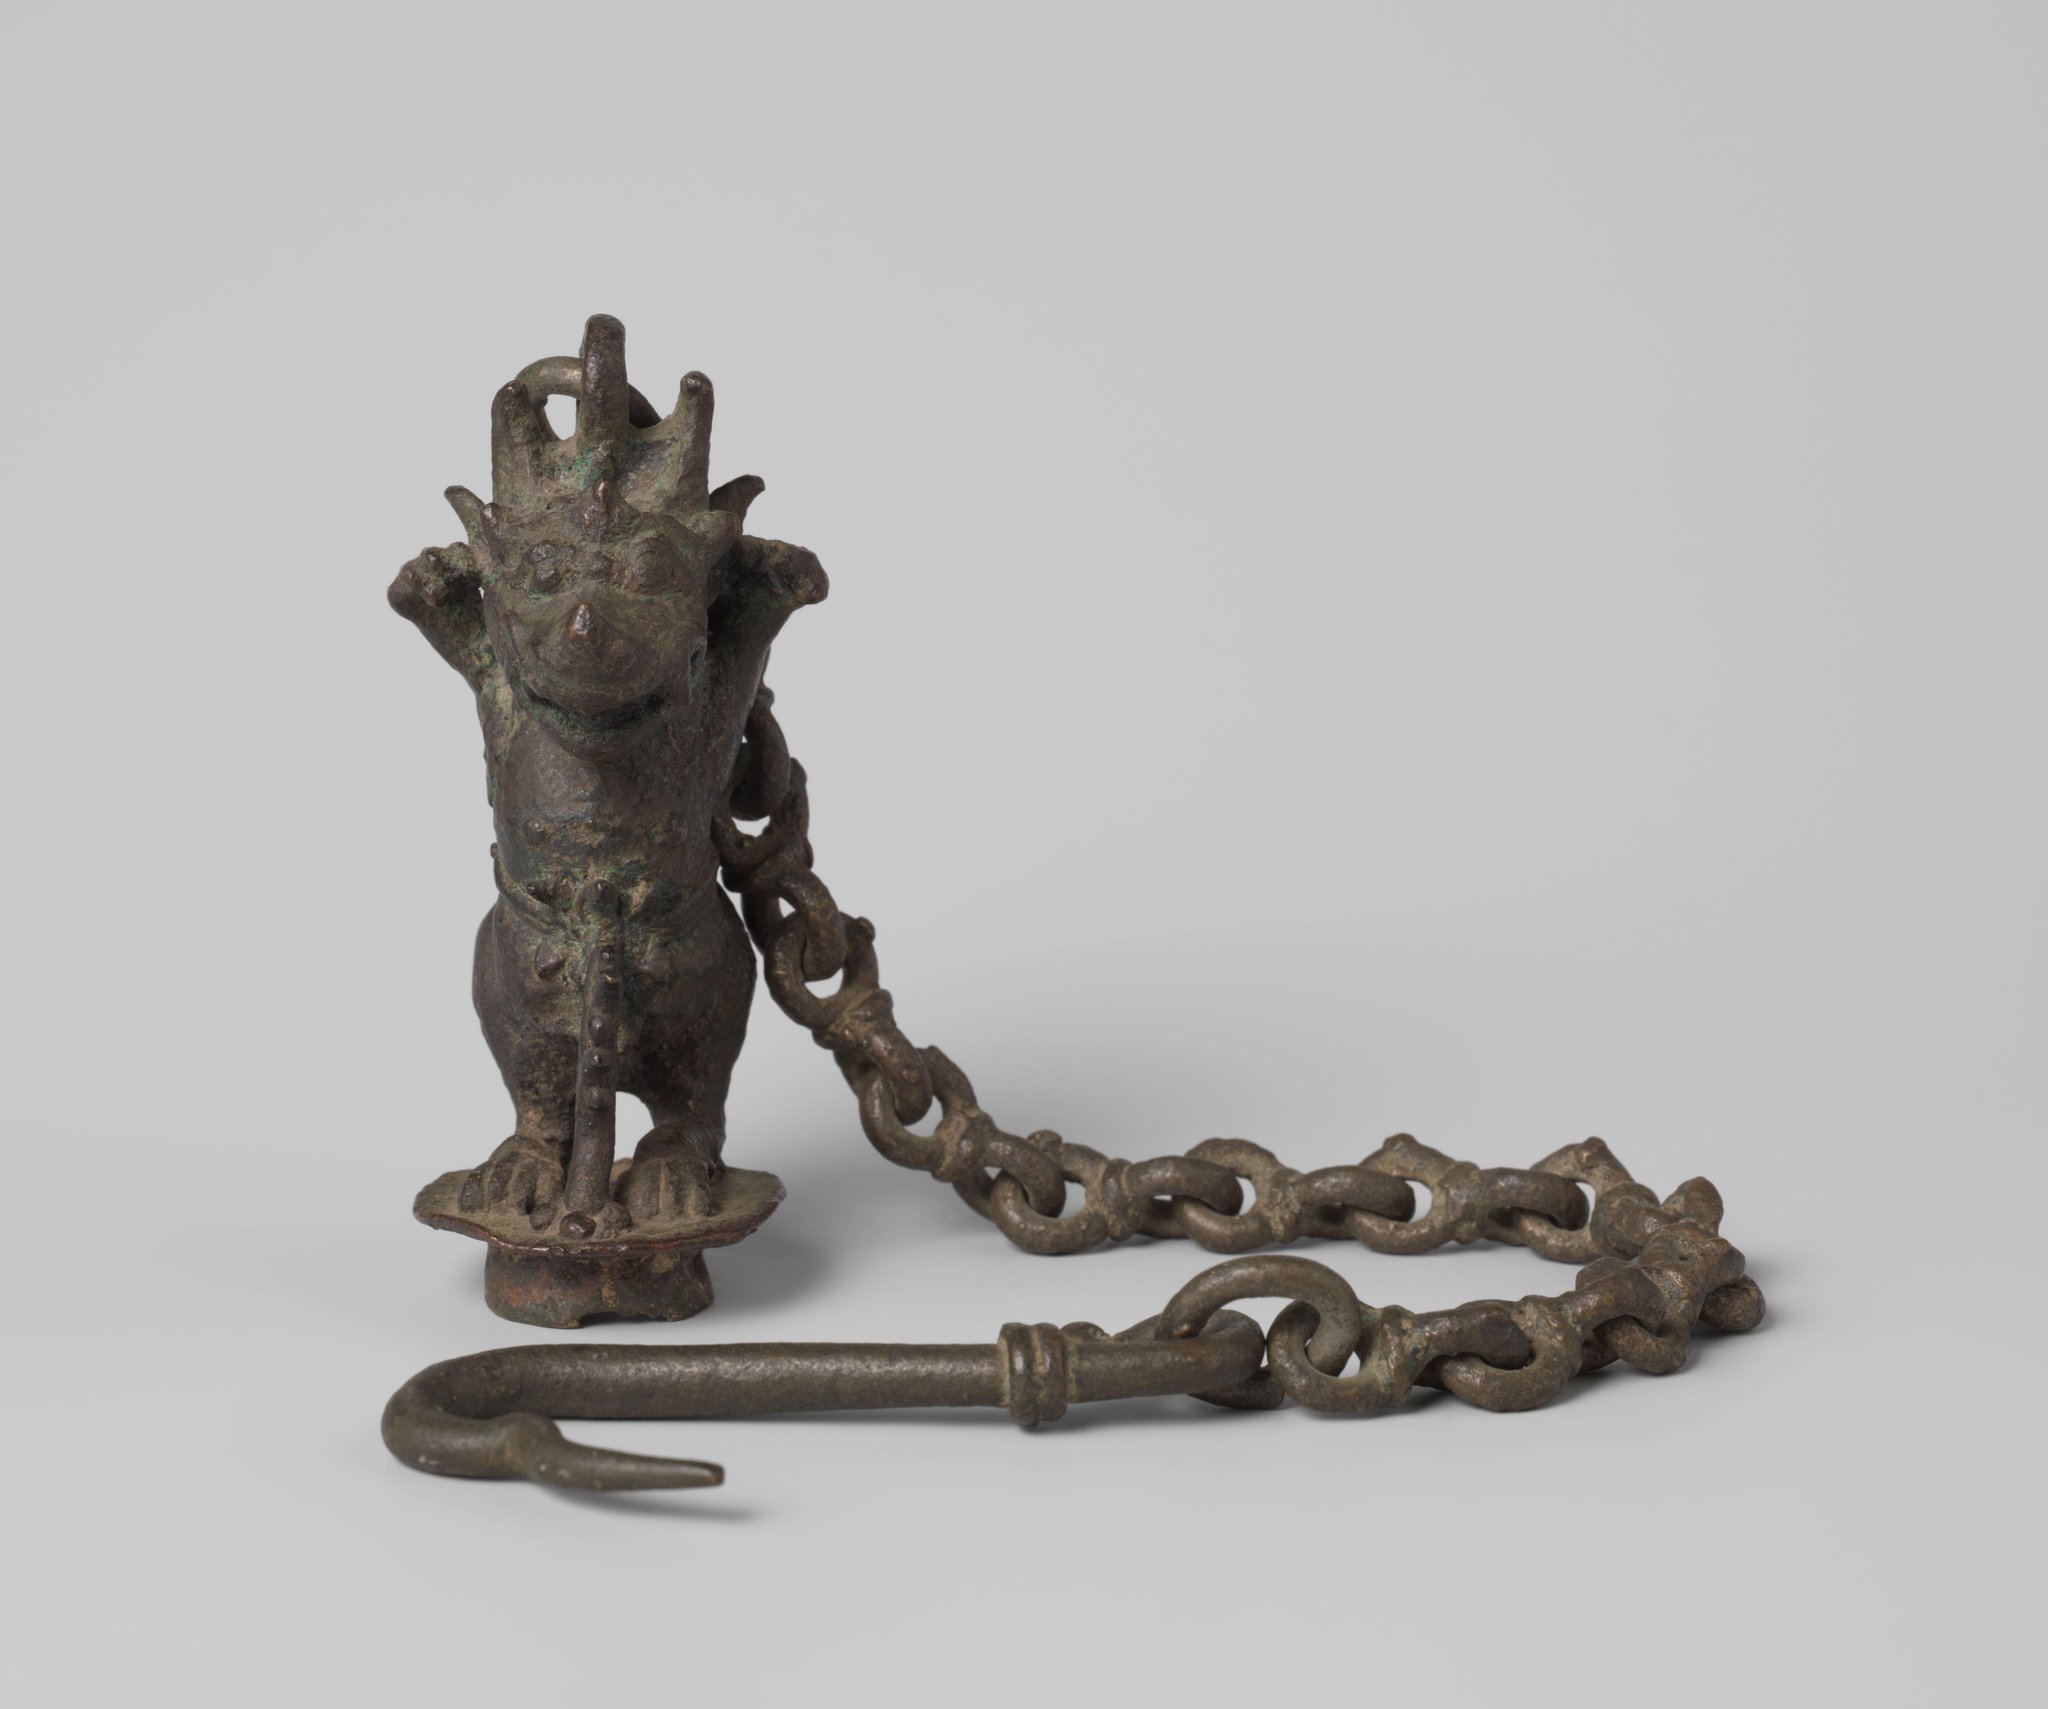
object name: fragment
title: Fragment van een klok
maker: Anonymous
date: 1200-1500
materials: bronze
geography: indonesia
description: Topstuk van een klok in de vorm van een opstaande leeuw, tussen horens ring waaraan ketting van 35 cm lengte, eindigend in haak. Staat op schijf.